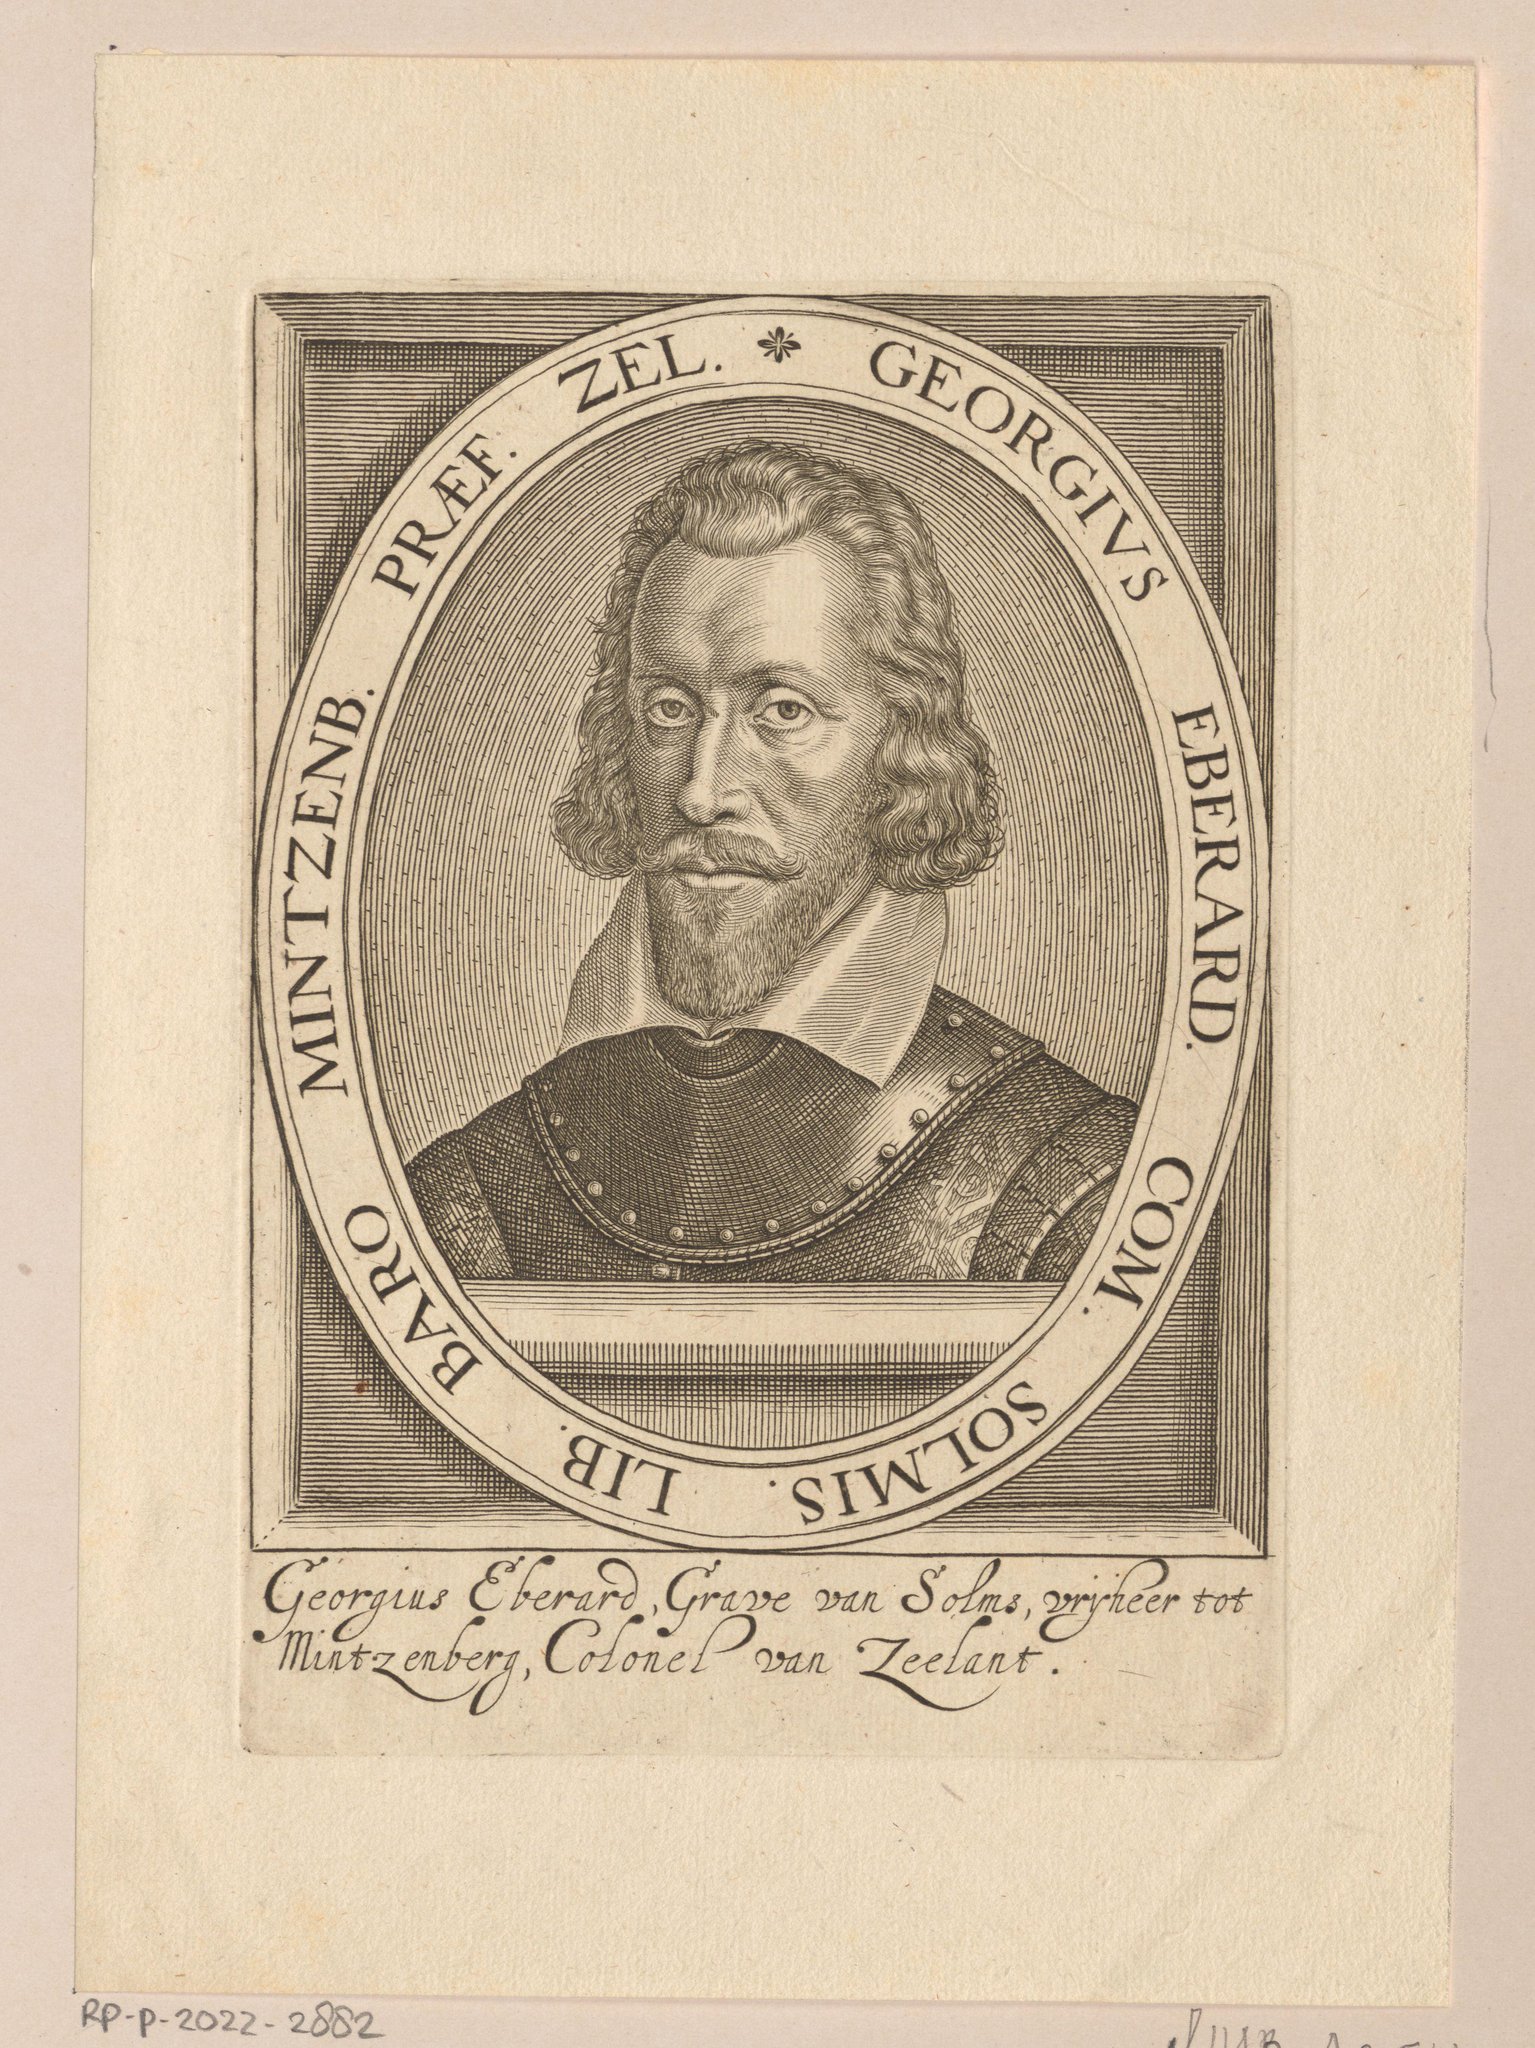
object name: print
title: Portret van Georg Eberhard van Solms-Lich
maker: Anonymous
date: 1614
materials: paper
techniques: engraving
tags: münzenberg en sonnewalde georg eberhard graaf van solms-lich, historical persons, other sovereign (with title)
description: Prent met tekst in boekdruk op recto en verso gebruikt in: Meteren, Emanuel van. Historie der Nederlandscher ende haerder na-buren oorlogen ende geschiedenissen (...). Den Haag: Hillebrant Jacobsz van Wouw, 1614.